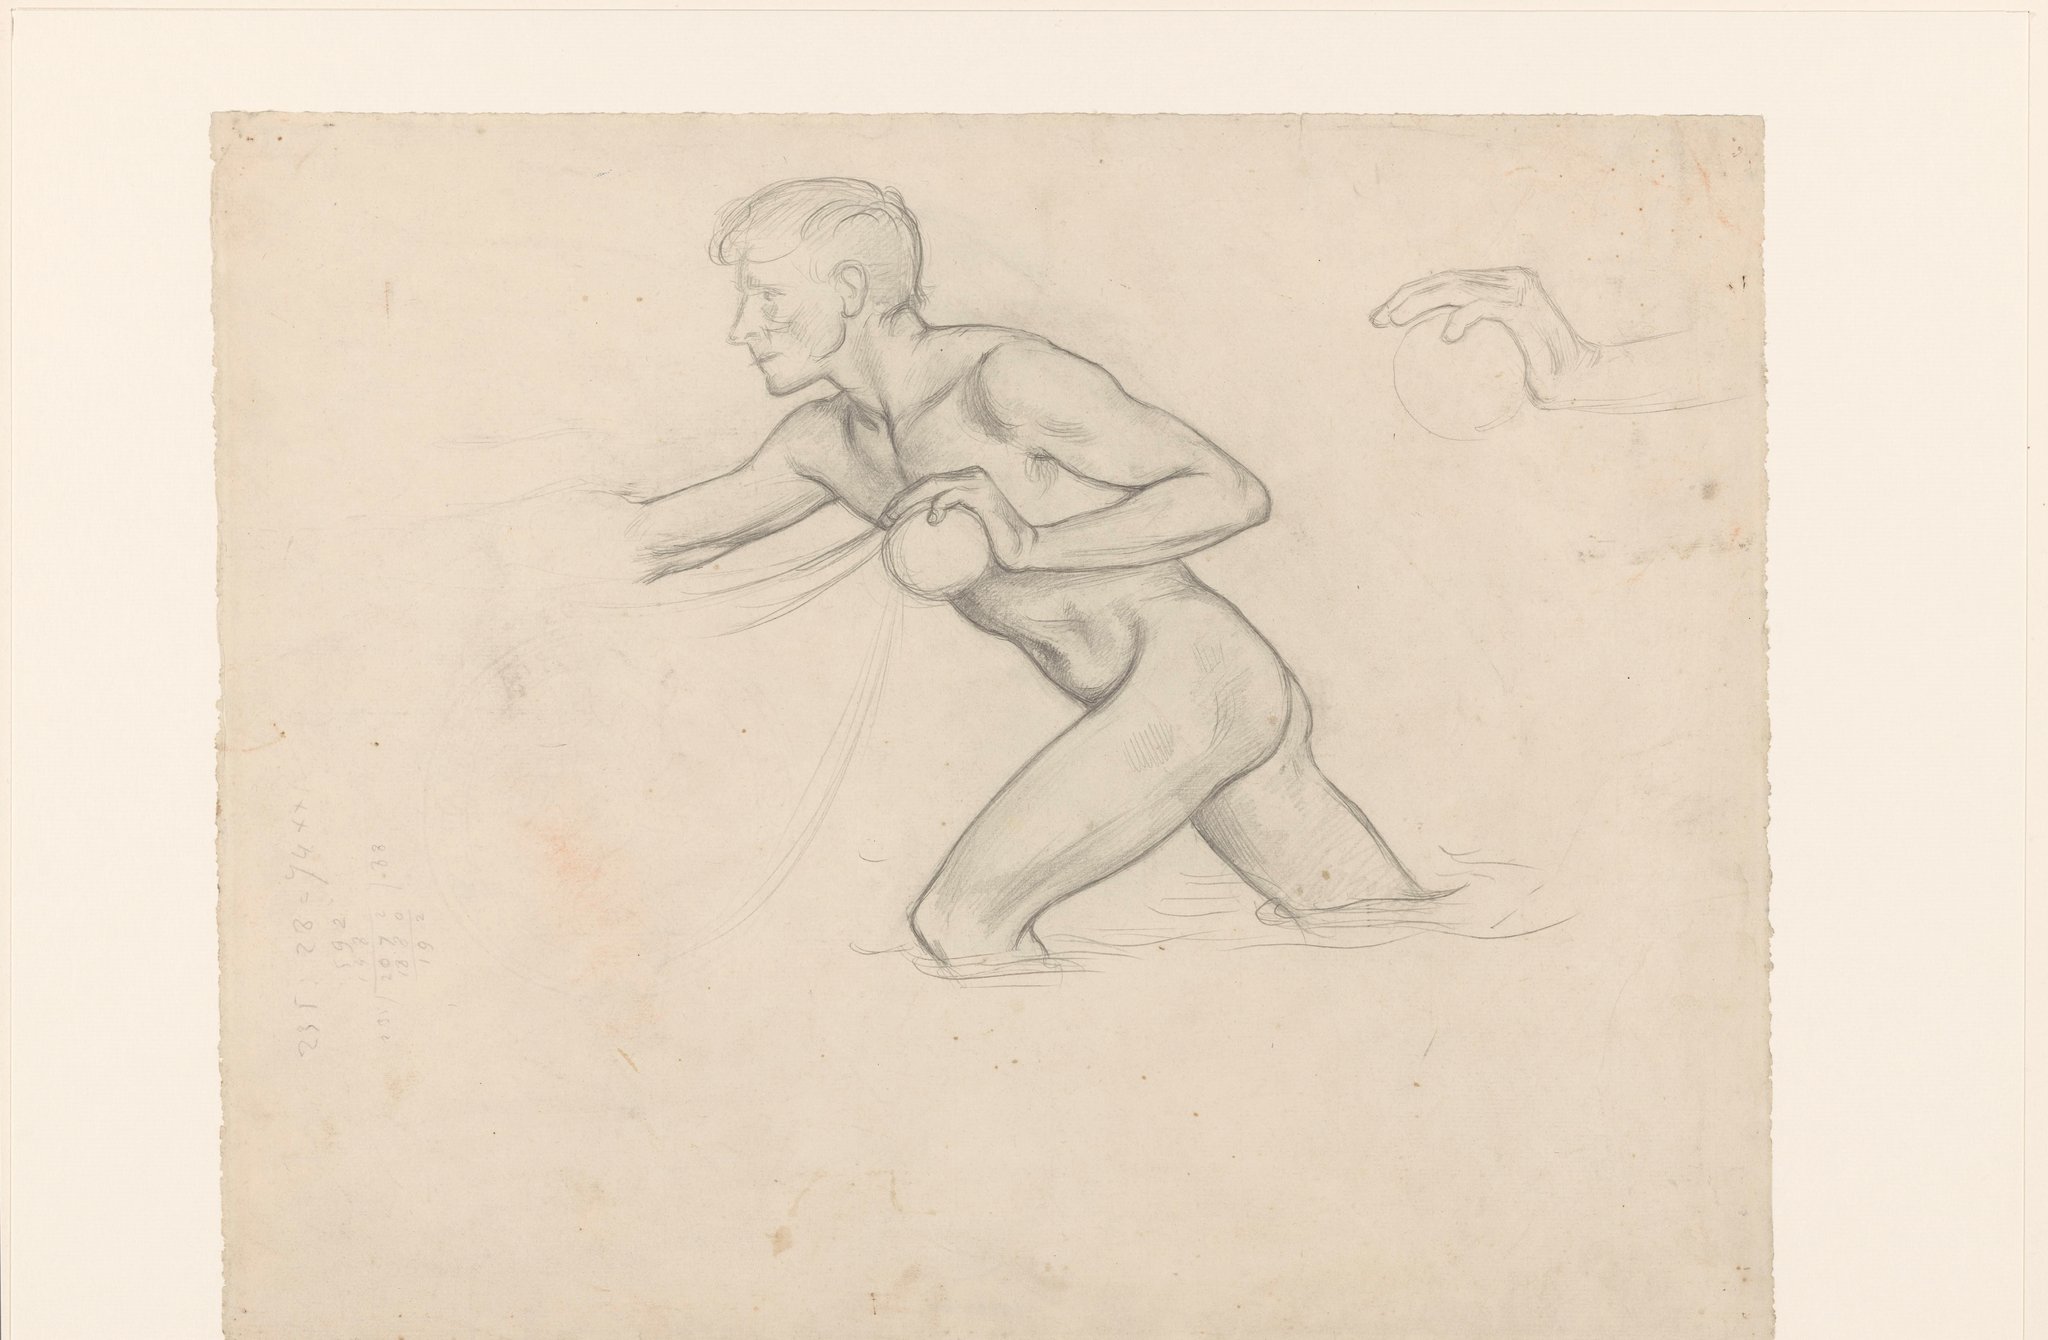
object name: drawing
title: Naakte jongen in het water, duwend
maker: richard nicolaüs roland holst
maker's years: 1868-1938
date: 1878-1938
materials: paper, pencil